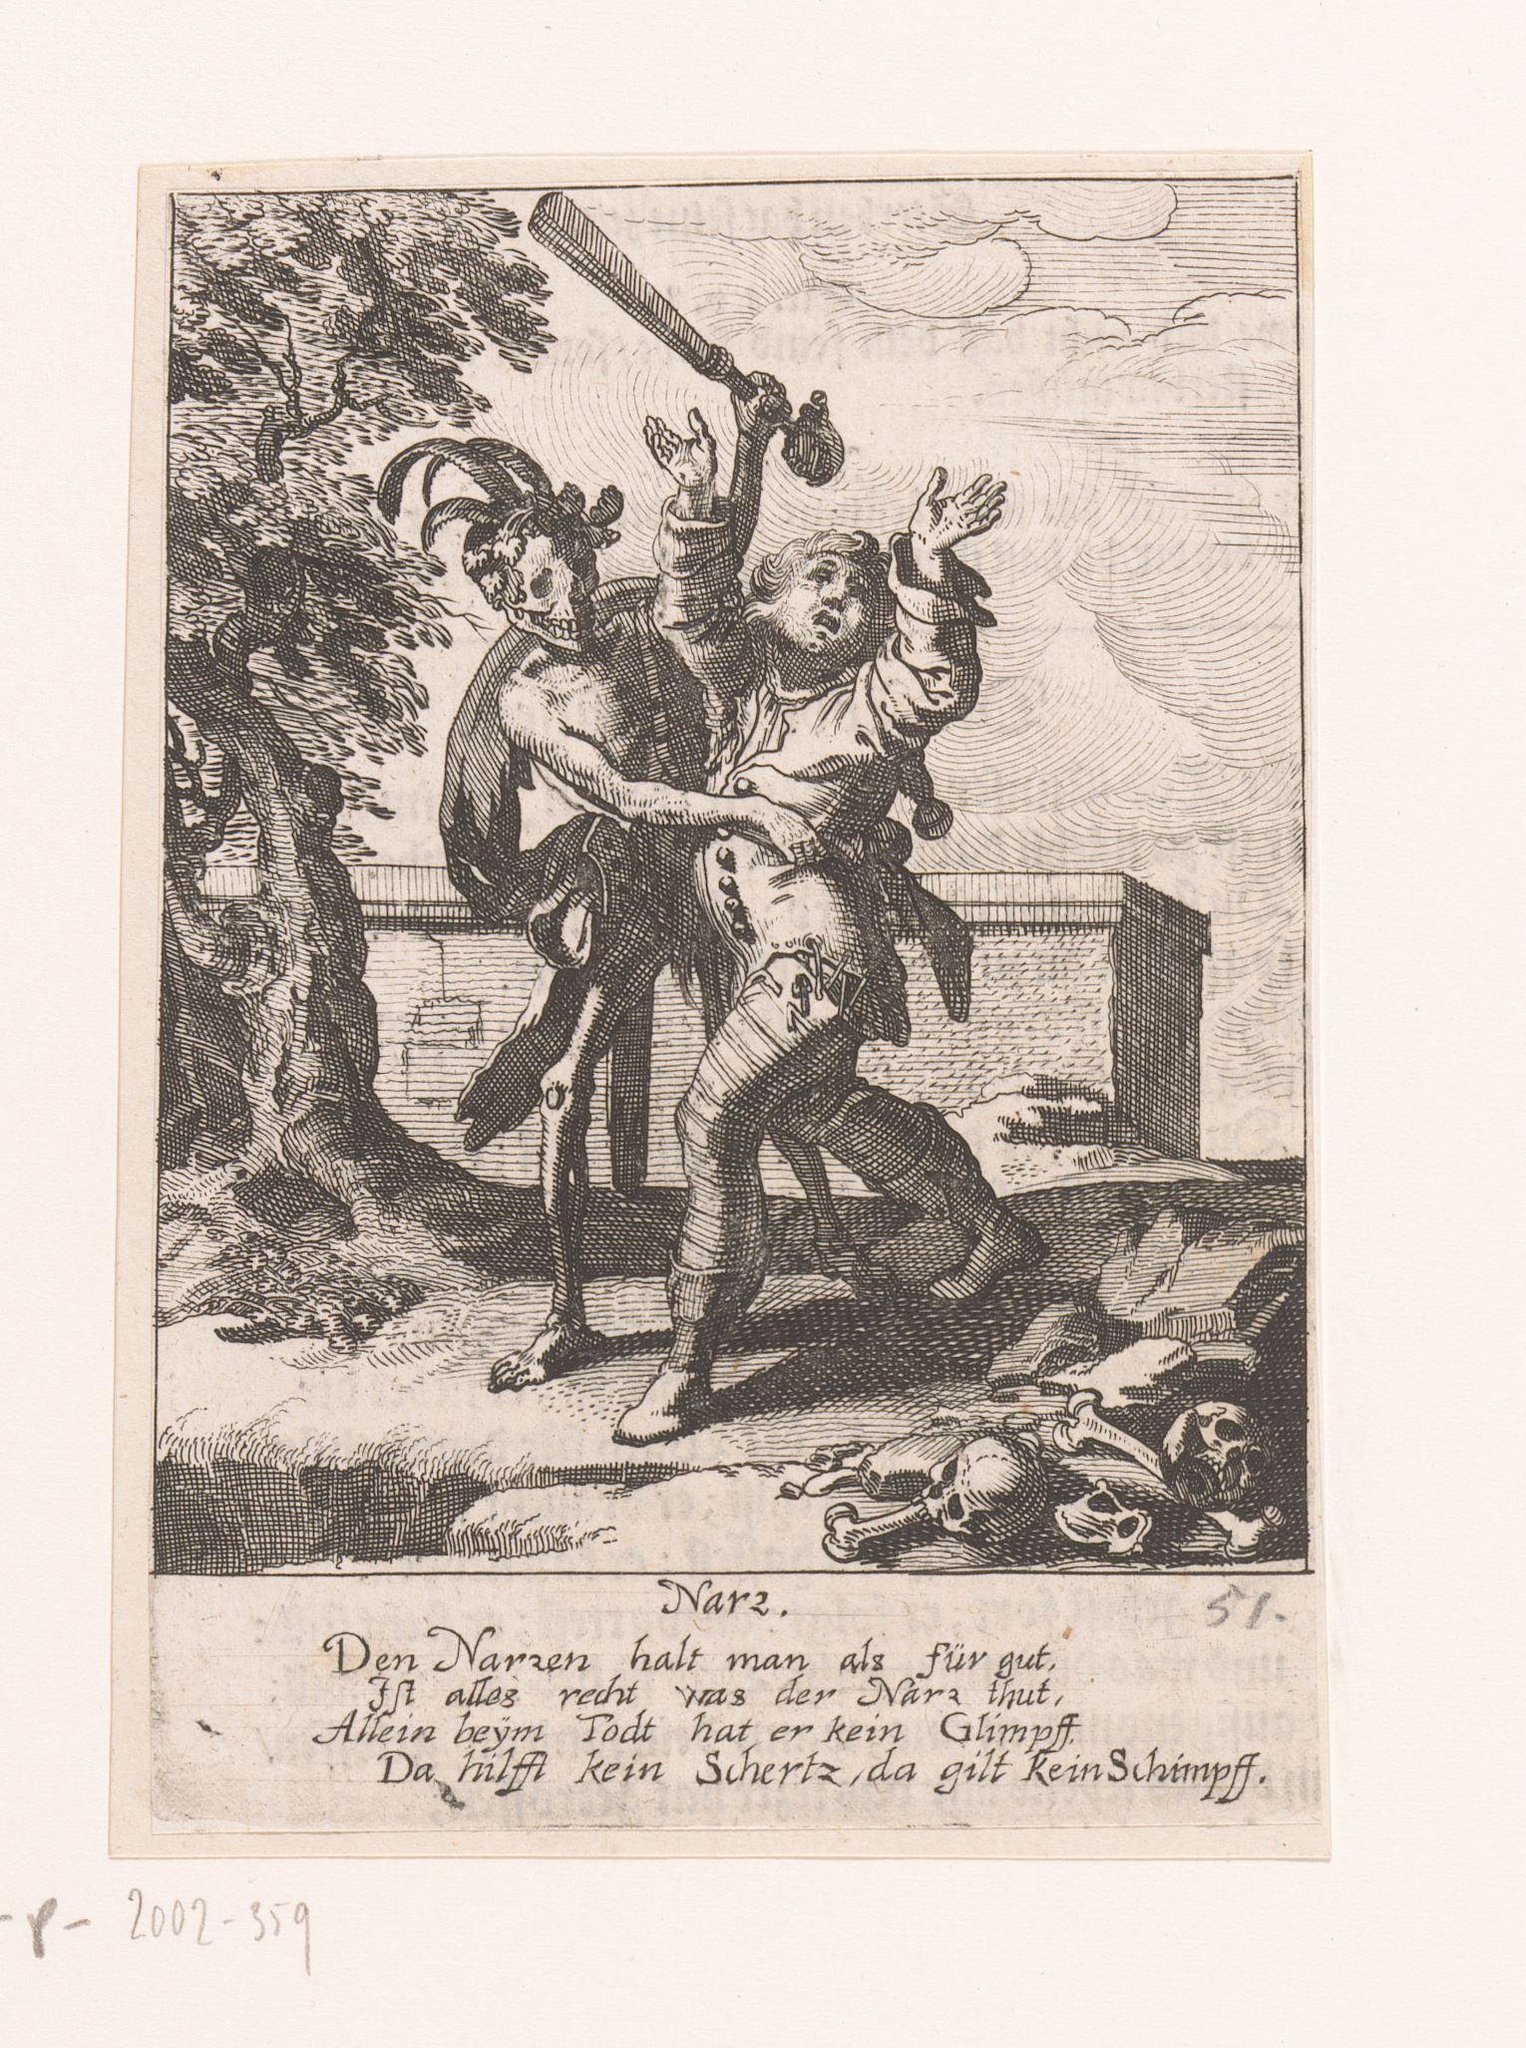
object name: print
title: Narz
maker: johann jakob bodmer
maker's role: printer, publisher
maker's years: 1629-1650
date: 1650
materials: paper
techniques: etching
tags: personifications of death; 'morte' (ripa), dance of death; death together with one or more human beings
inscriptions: collector's mark: Lugt 2228, collector's mark: Lugt 2233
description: Prent uit: Meyer, Rudolph. Sterbenspiegel, das ist sonnenklare Vorstellung menschlicher Nichtigkeit durch alle Ständ und Geschlechter (...). Zürich: J.J. Bodmer, 1650.